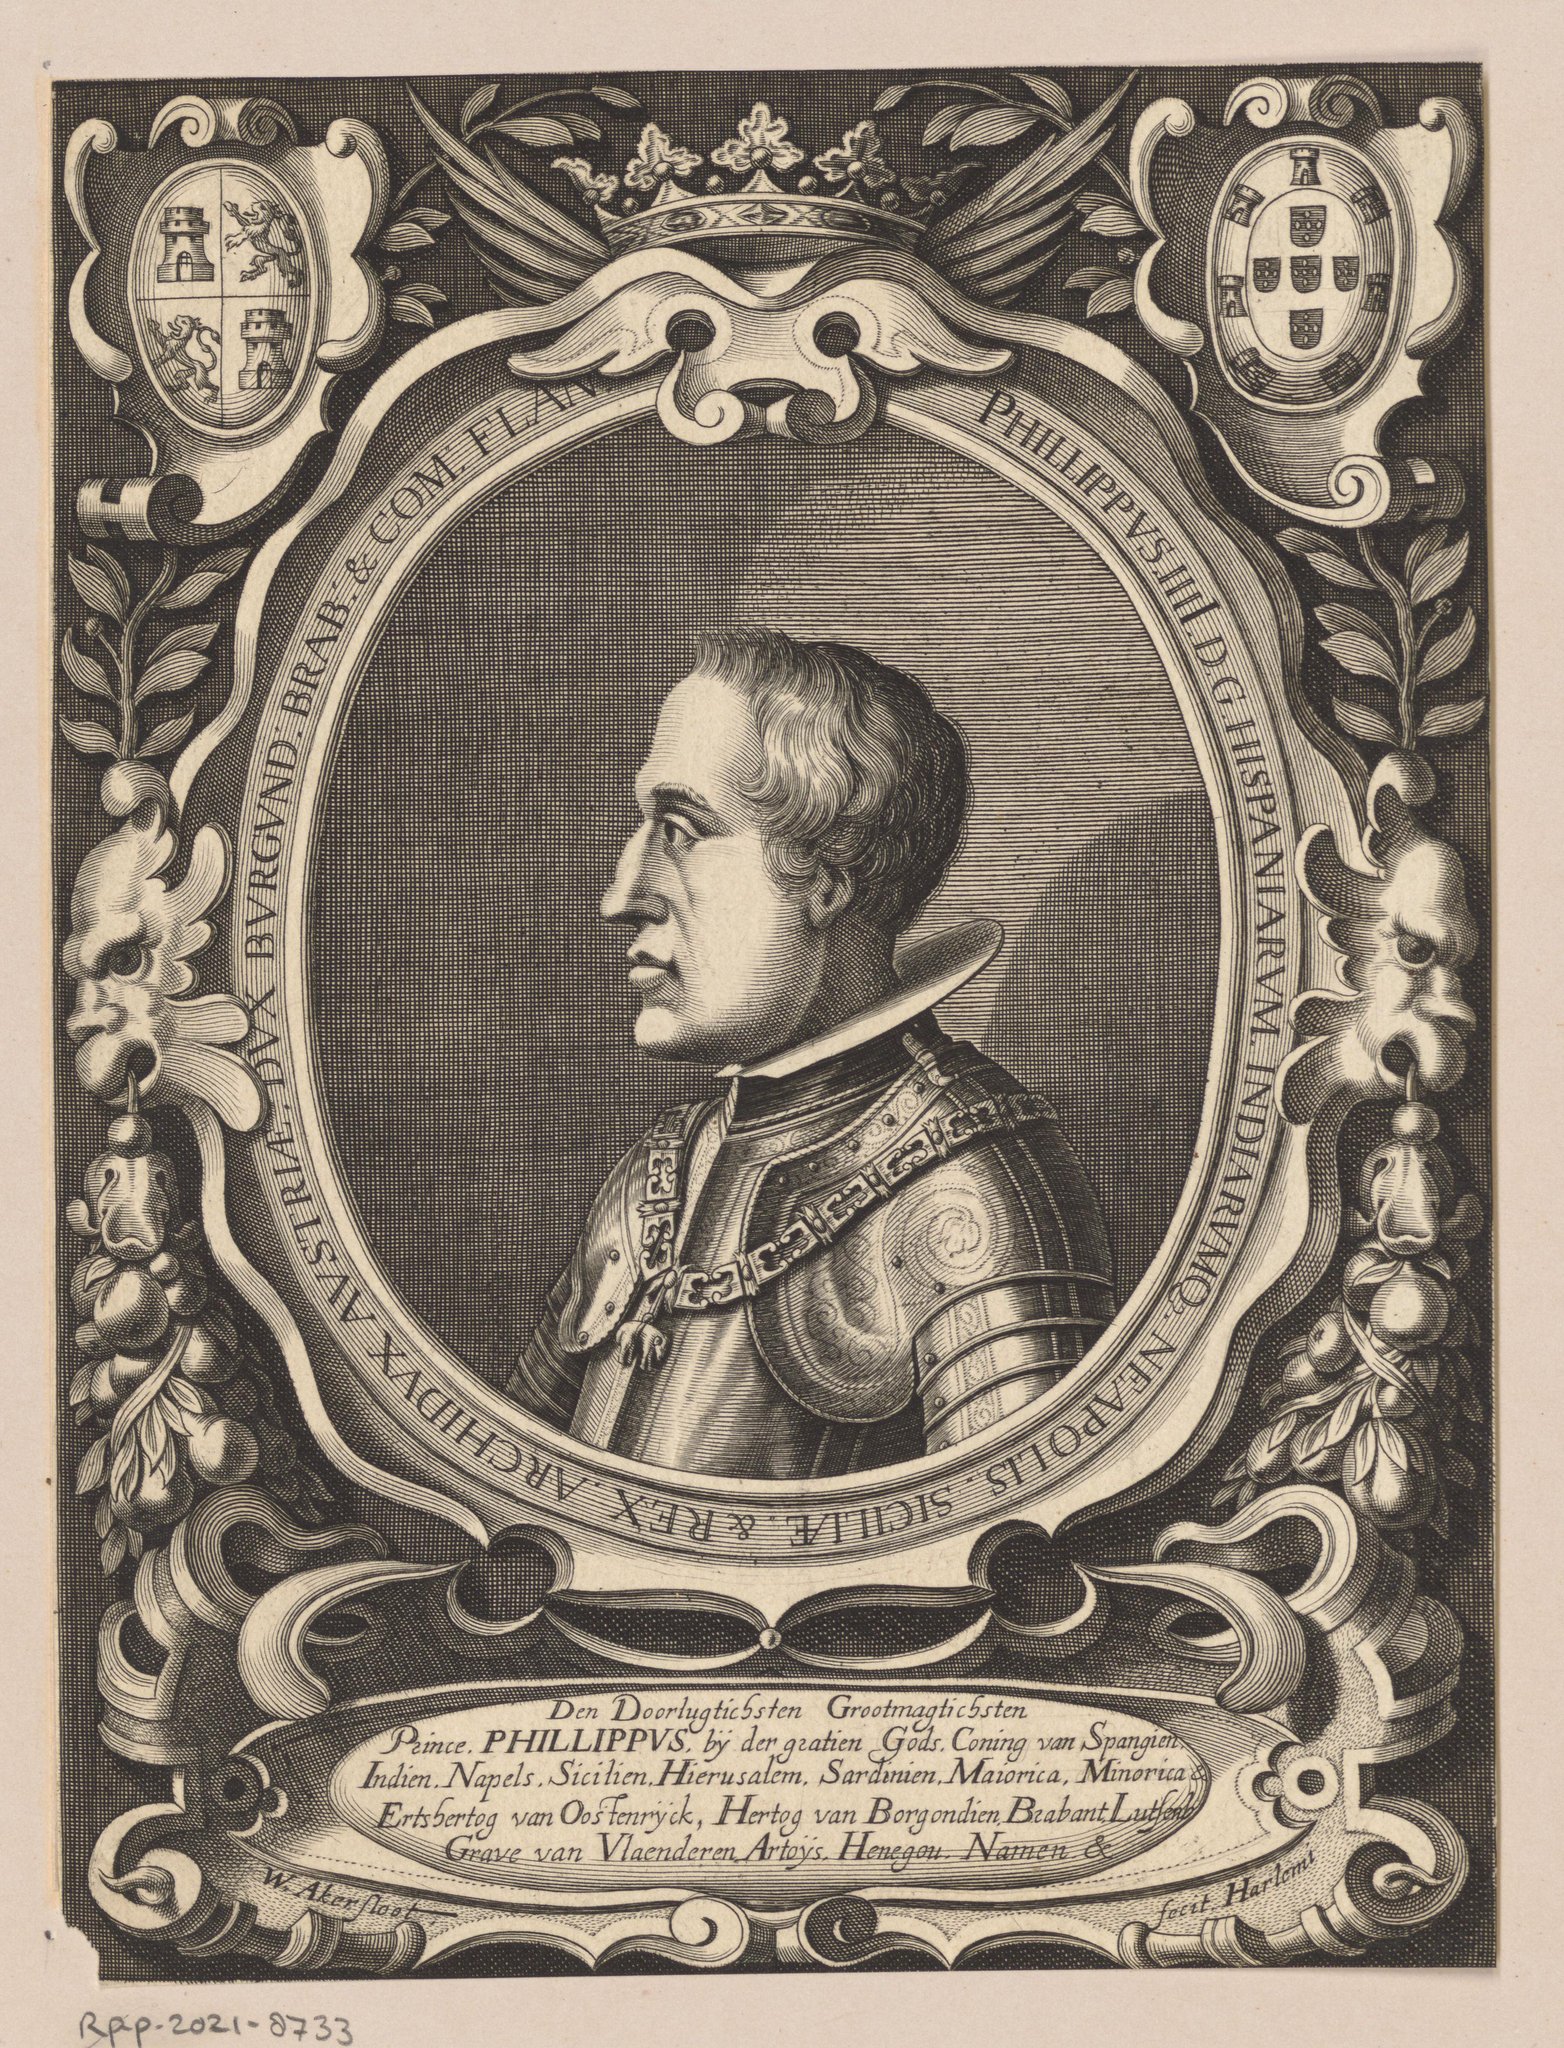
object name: print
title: Portret van Filips IV, koning van Spanje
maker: willem outgertsz. akersloot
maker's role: print maker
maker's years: 1600-1651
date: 1610-1633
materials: paper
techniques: engraving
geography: haarlem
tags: filips iv (koning van spanje), adult man, historical persons, knighthood order of the golden fleece